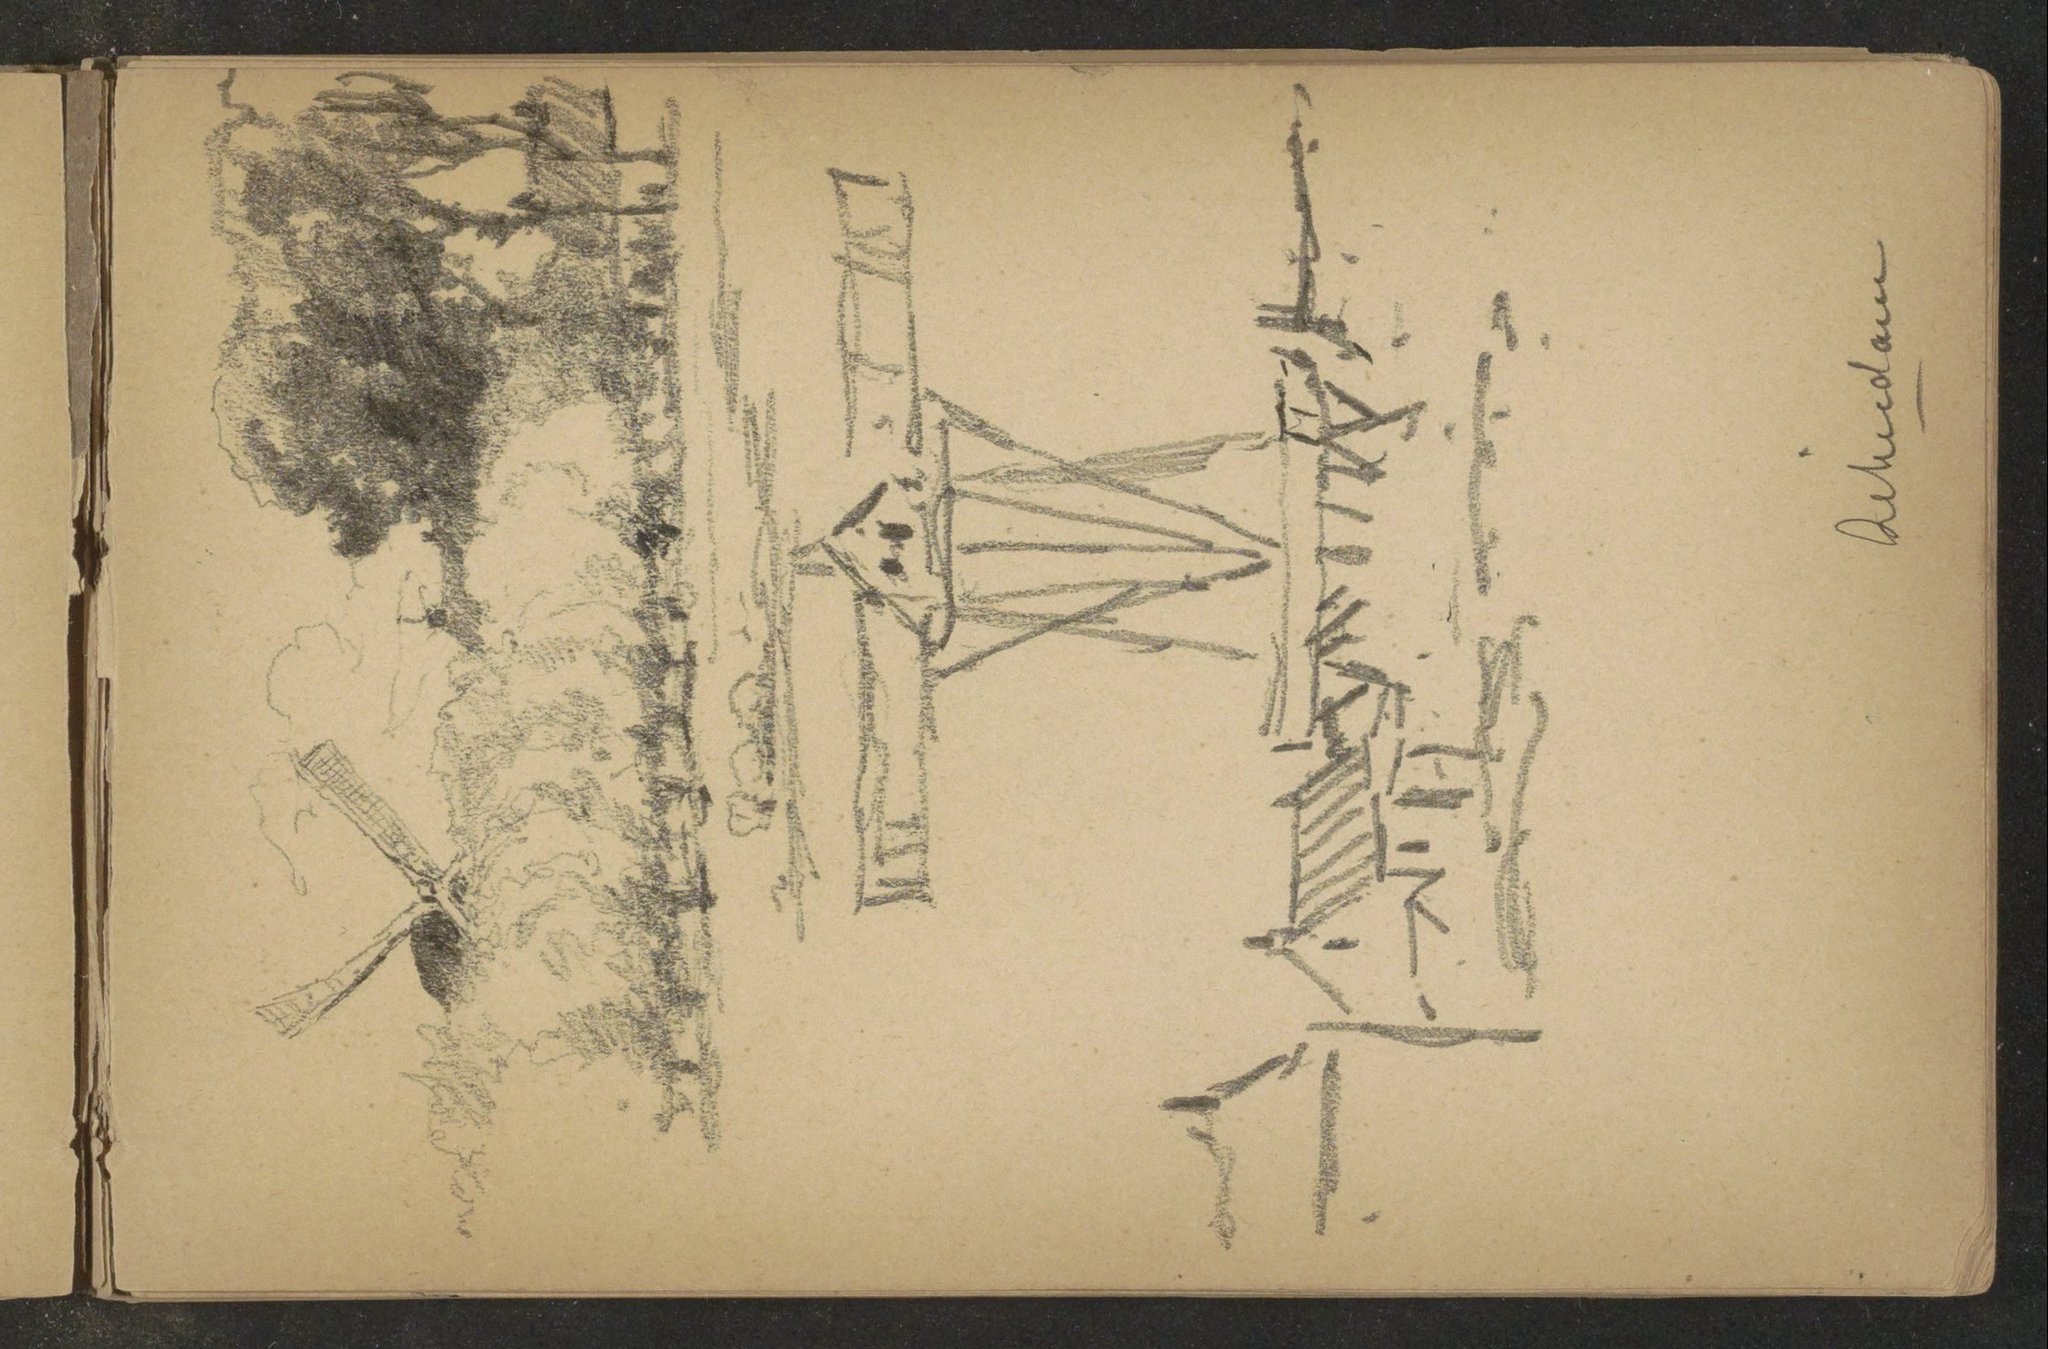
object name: sketchbook leaf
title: Dorpsgezichten met molens te Schiedam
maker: alexander shilling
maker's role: draughtsman, print maker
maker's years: 1859-1937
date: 1809-1888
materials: paper, pencil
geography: schiedam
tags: village, windmill in landscape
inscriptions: annotation: ‘Schiedam’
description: Blad 4 recto uit een schetsboek met 34 bladen.